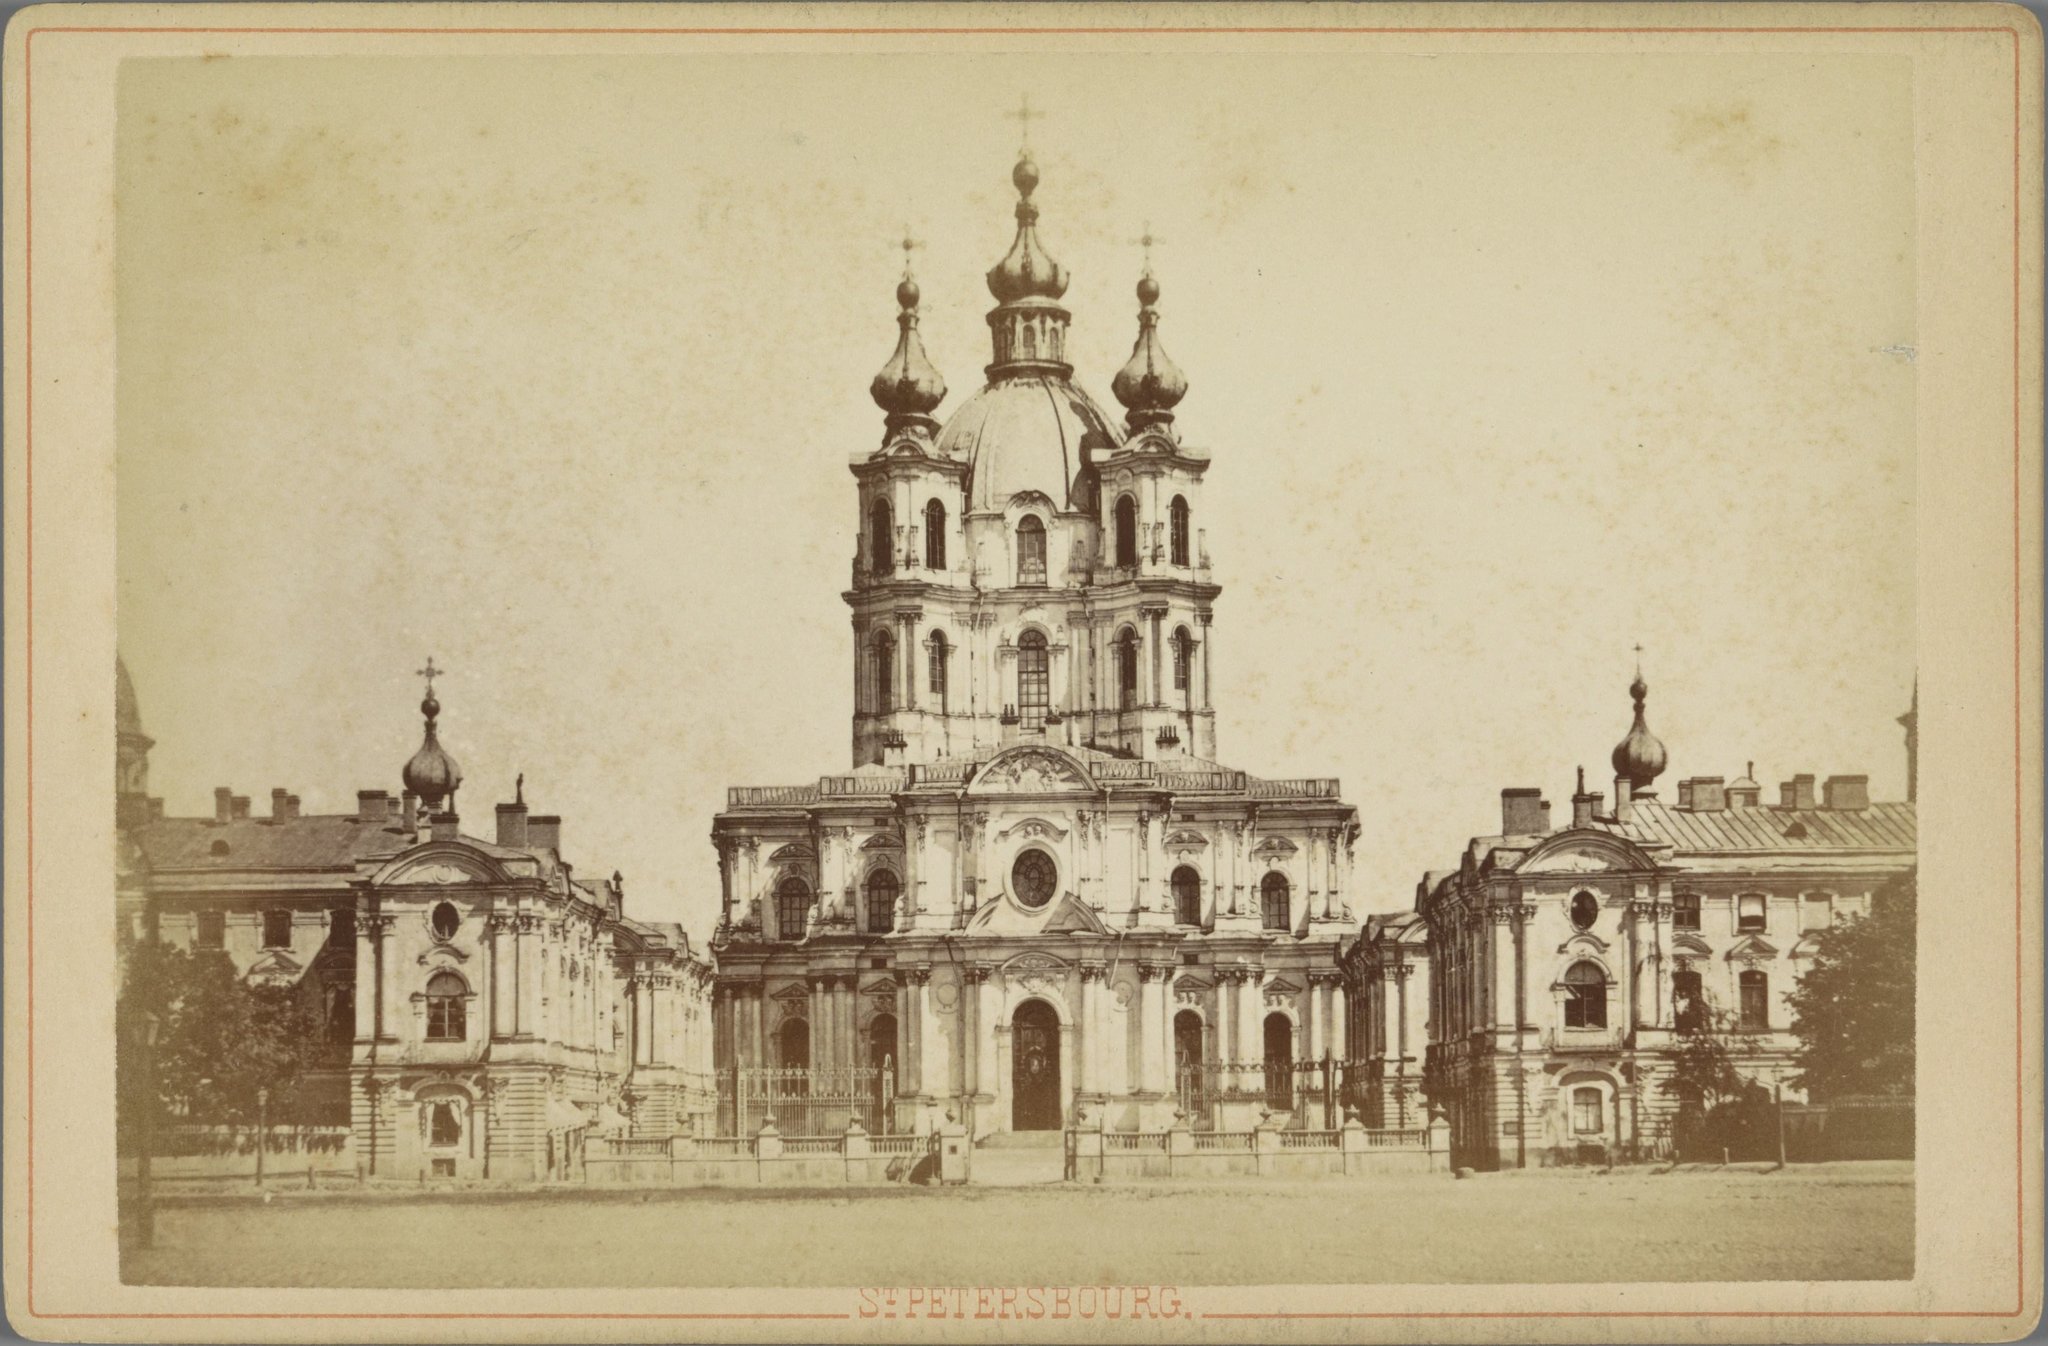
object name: cabinet photograph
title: St. Petersbourg.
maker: joseph daziaro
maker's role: publisher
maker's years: 1831-1892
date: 1880-1900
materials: cardboard, photographic support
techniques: albumen print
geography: sint-petersburg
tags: abbey, monastery, convent ~ roman catholic church, church (exterior)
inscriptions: inscription: ‘Couvent de Smolna’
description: Onderdeel van Fotoalbum met opnames van Sint-Petersburg.